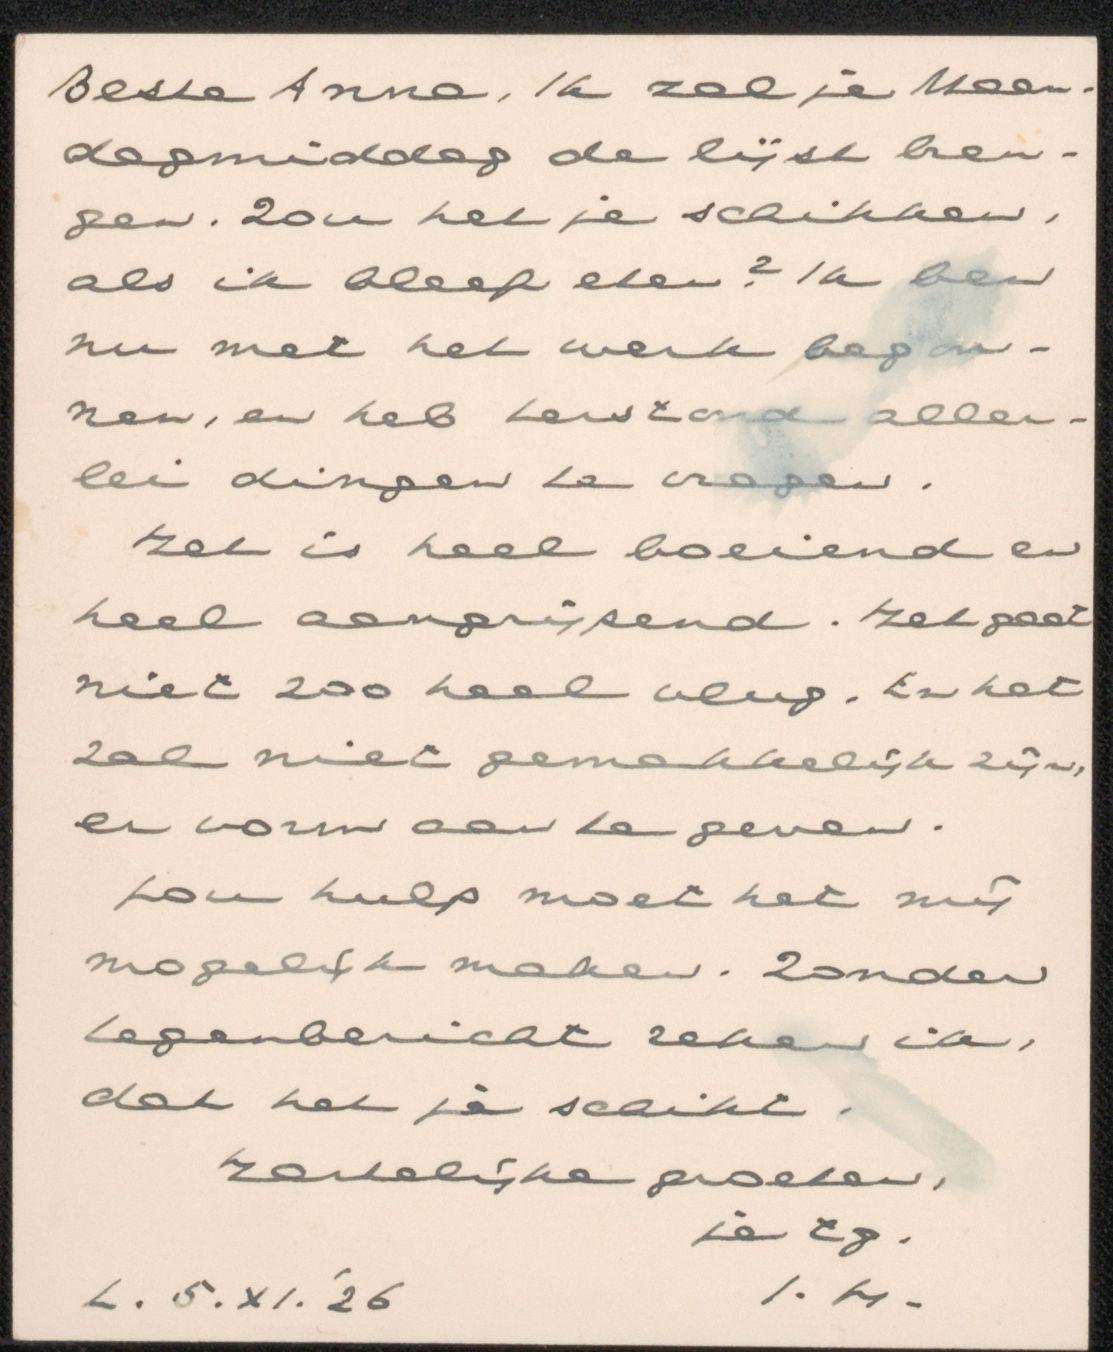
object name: letter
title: Brief aan Anna Dorothea Dirks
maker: johan huizinga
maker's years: 1872-1945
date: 1926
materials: ink, paper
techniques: pen, writing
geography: leiden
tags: artist, anna dorothea dirks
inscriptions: collector's mark: ‘RPK’